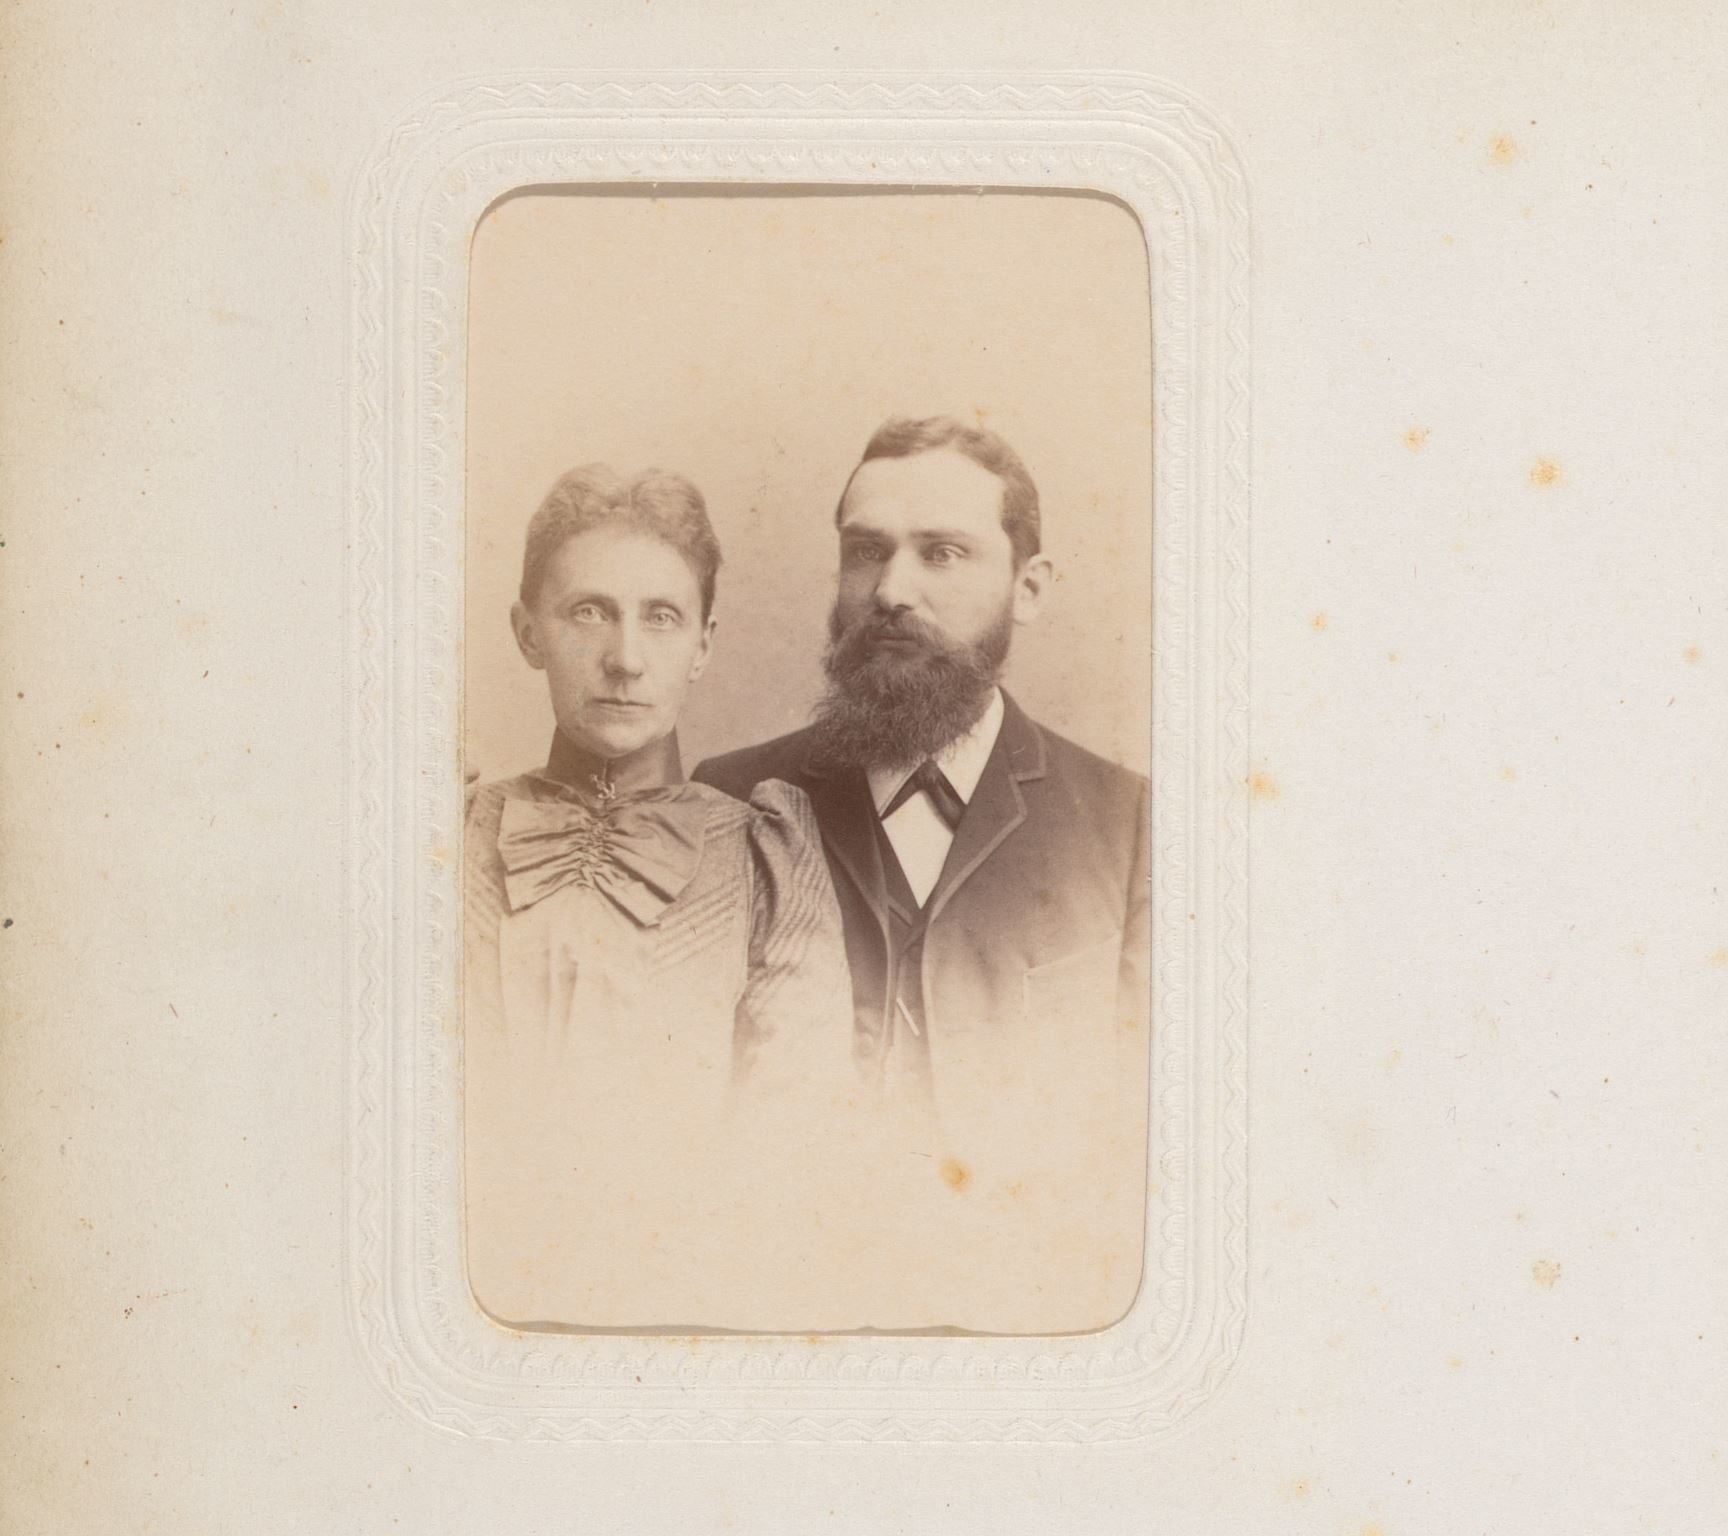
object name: carte de visite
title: Portret van een man en een vrouw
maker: ernst wolffram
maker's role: fotograaf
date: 1883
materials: cardboard, photographic support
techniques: albumen print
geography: bremen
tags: historical persons - bb - woman, historical persons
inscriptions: inscription: ‘Ernst Wolffram/ 14, FEDELHÖREN 14./ BREMEN.’, date: ‘15MAI83’